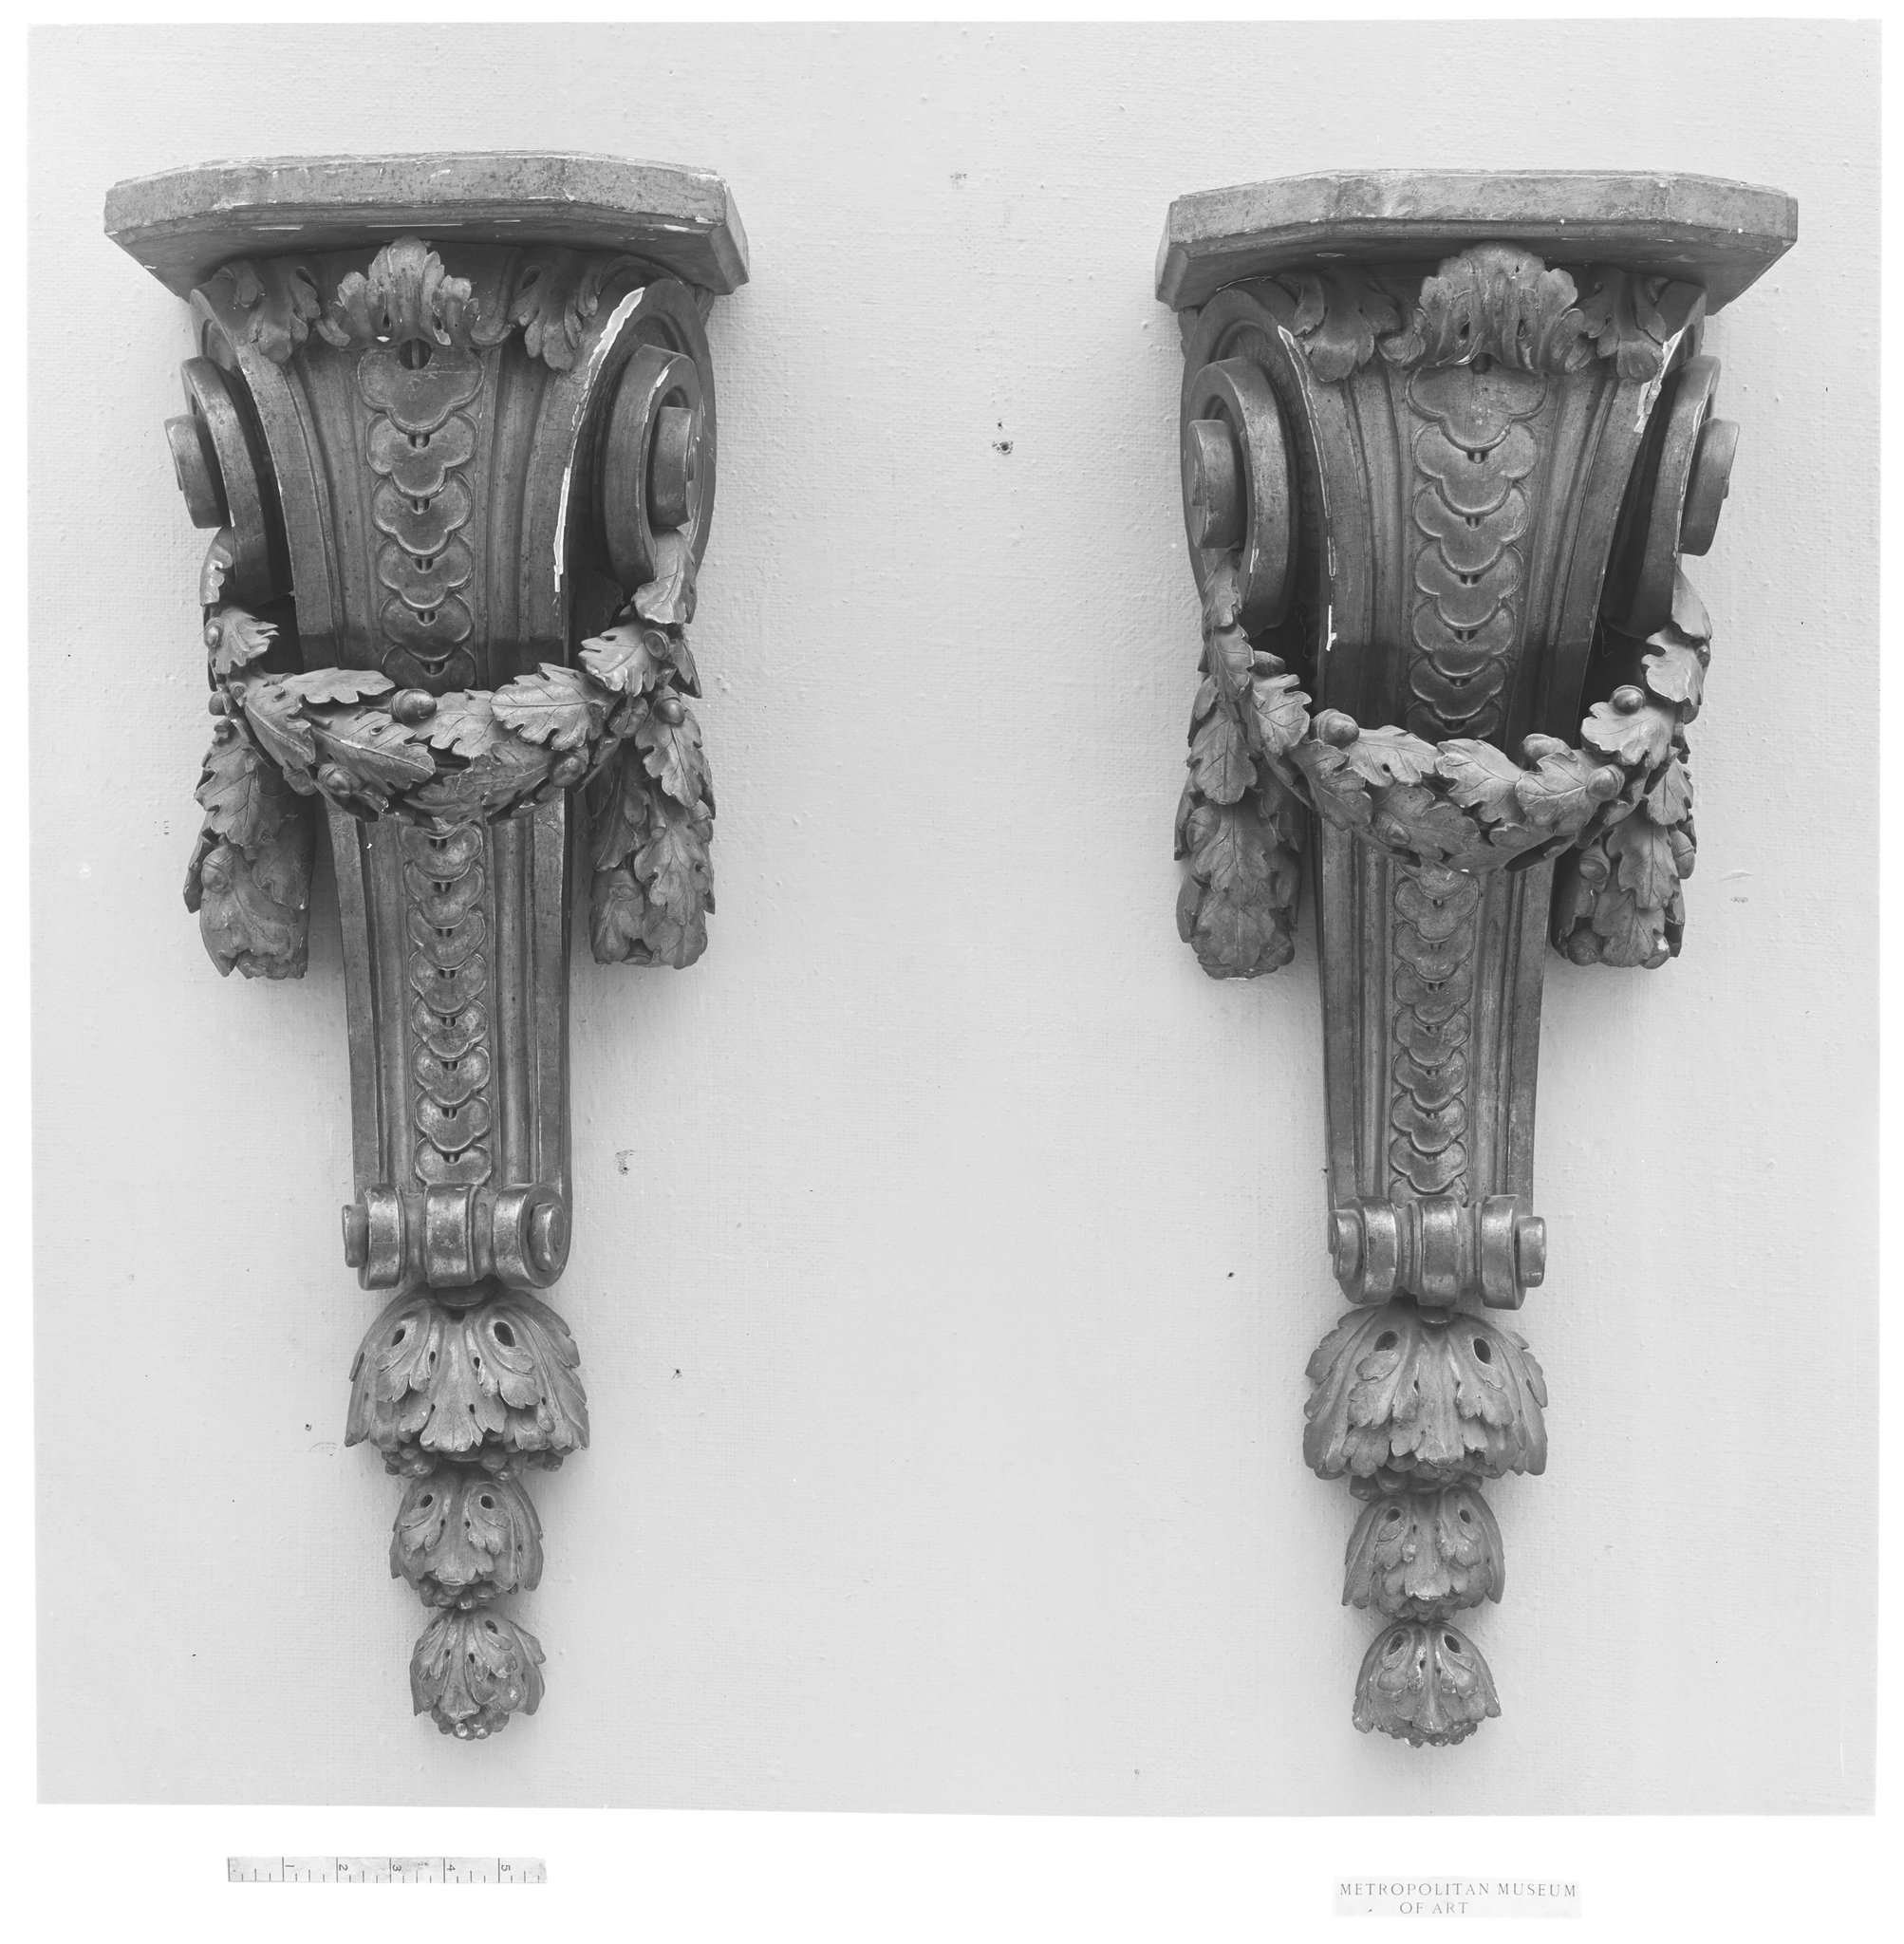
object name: console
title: Pair of consoles (consoles d'appliques)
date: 1701-1800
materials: wood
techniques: carving, gilding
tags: garlands,leaves